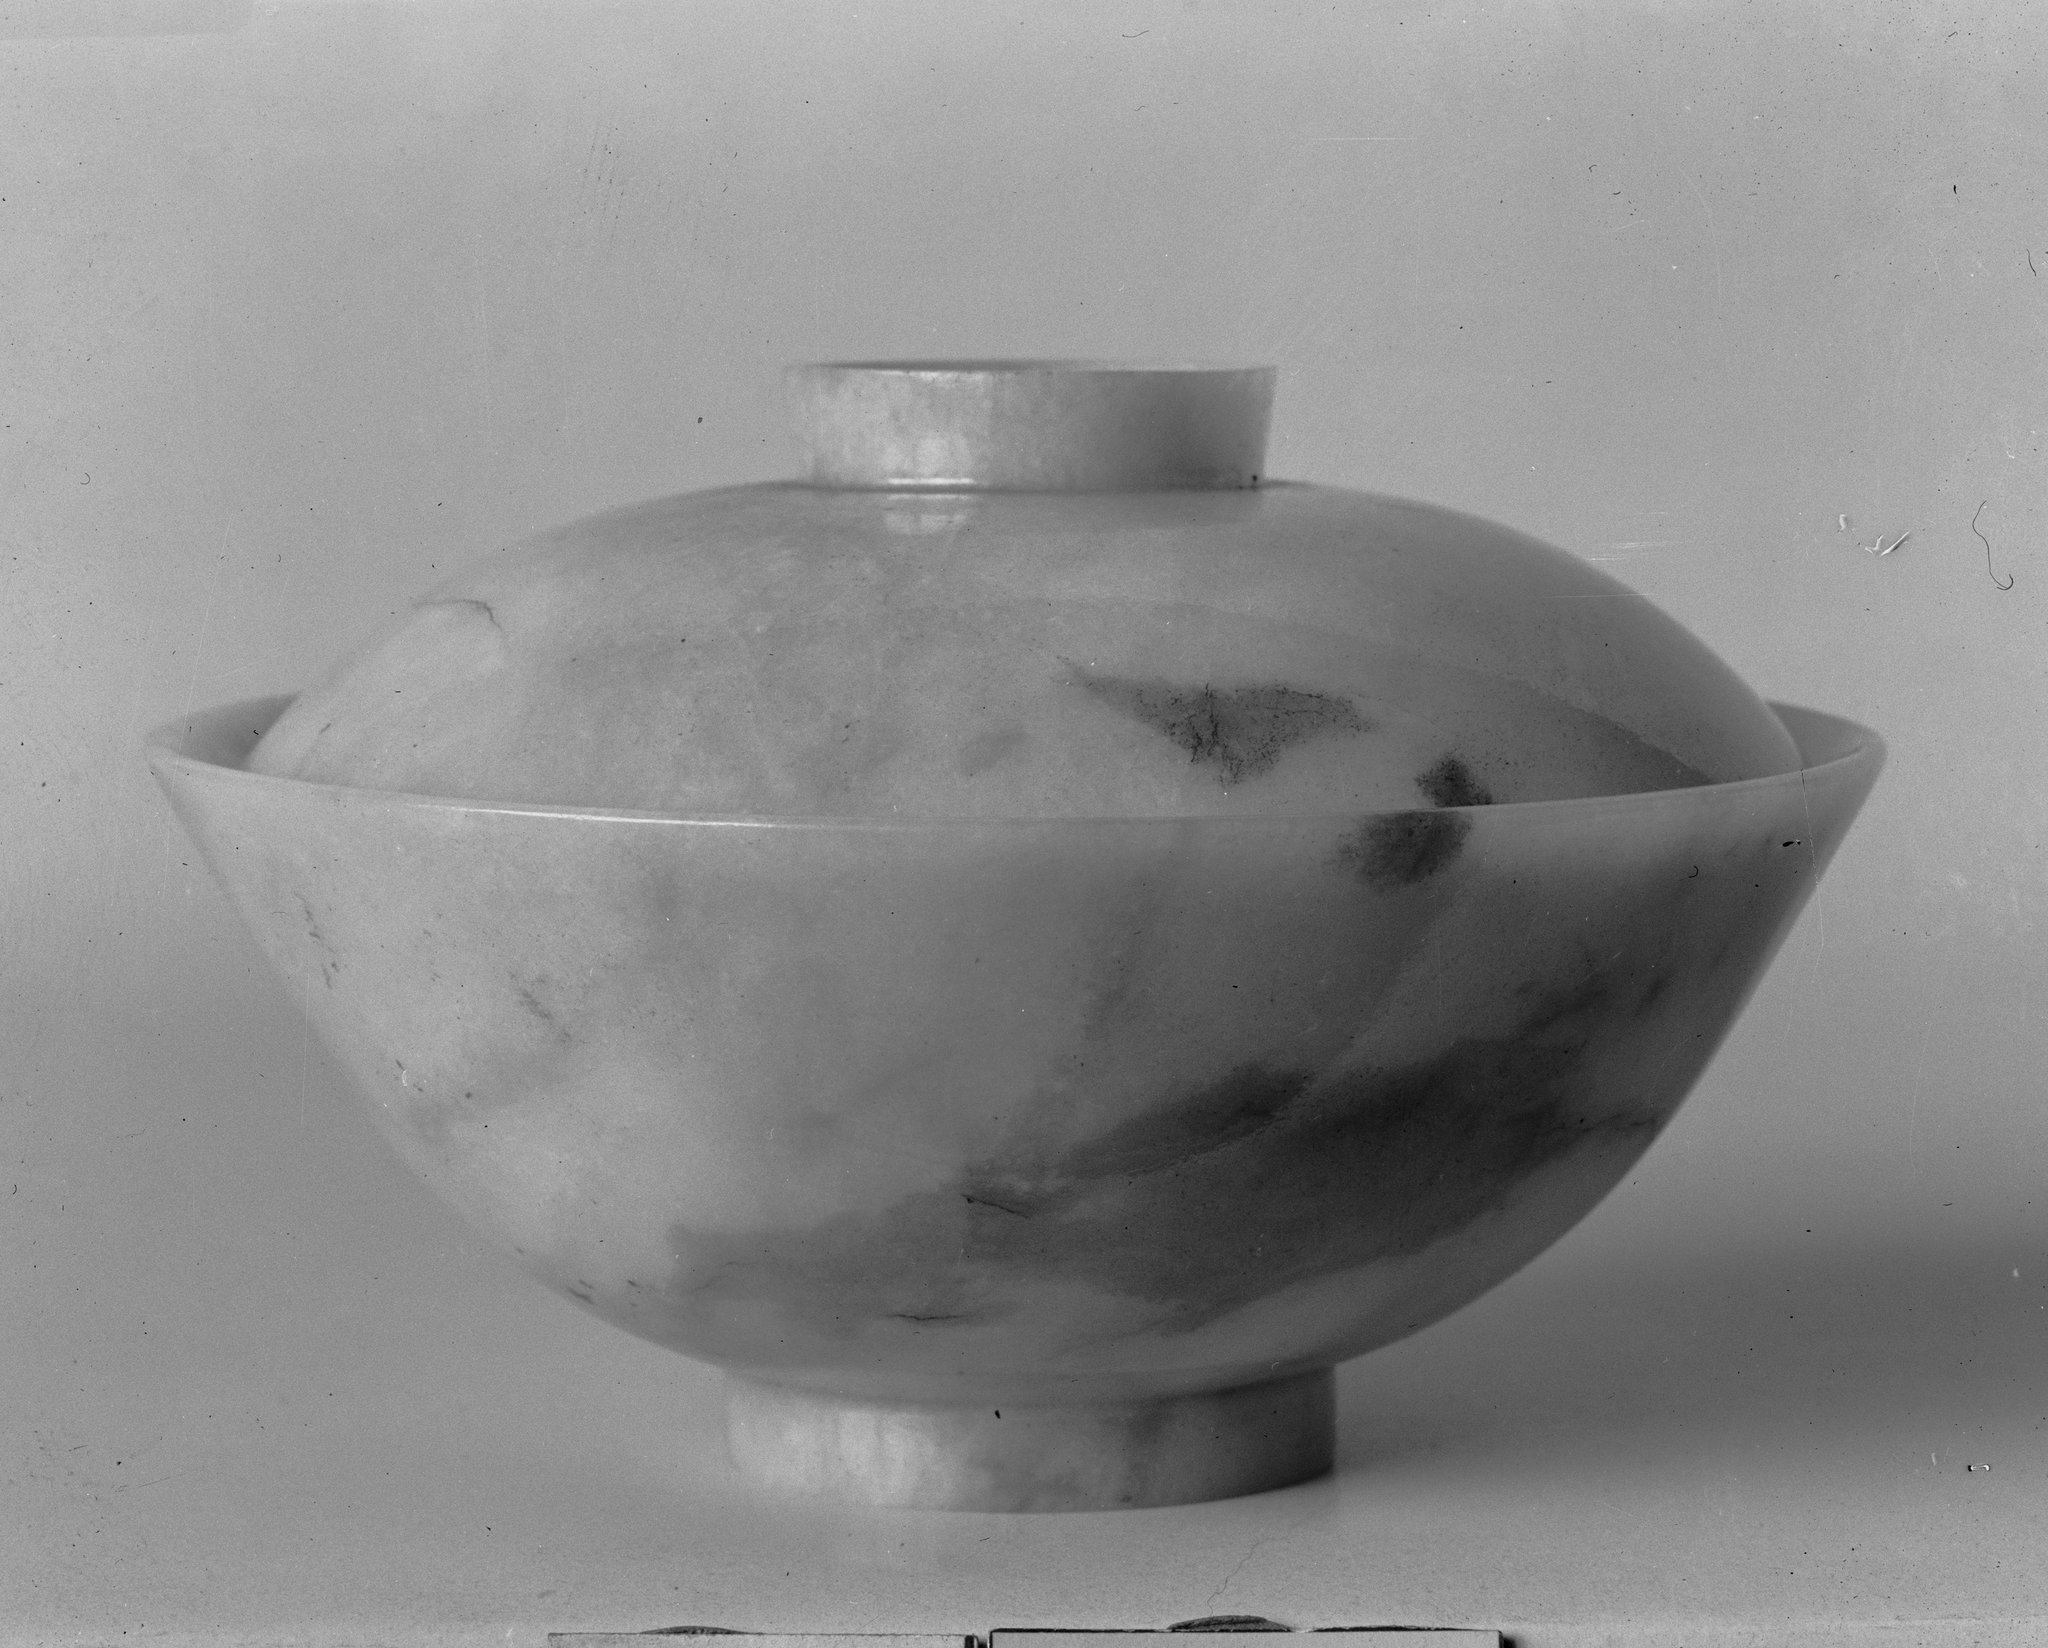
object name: covered bowl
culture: chinese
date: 1736-1795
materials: jade